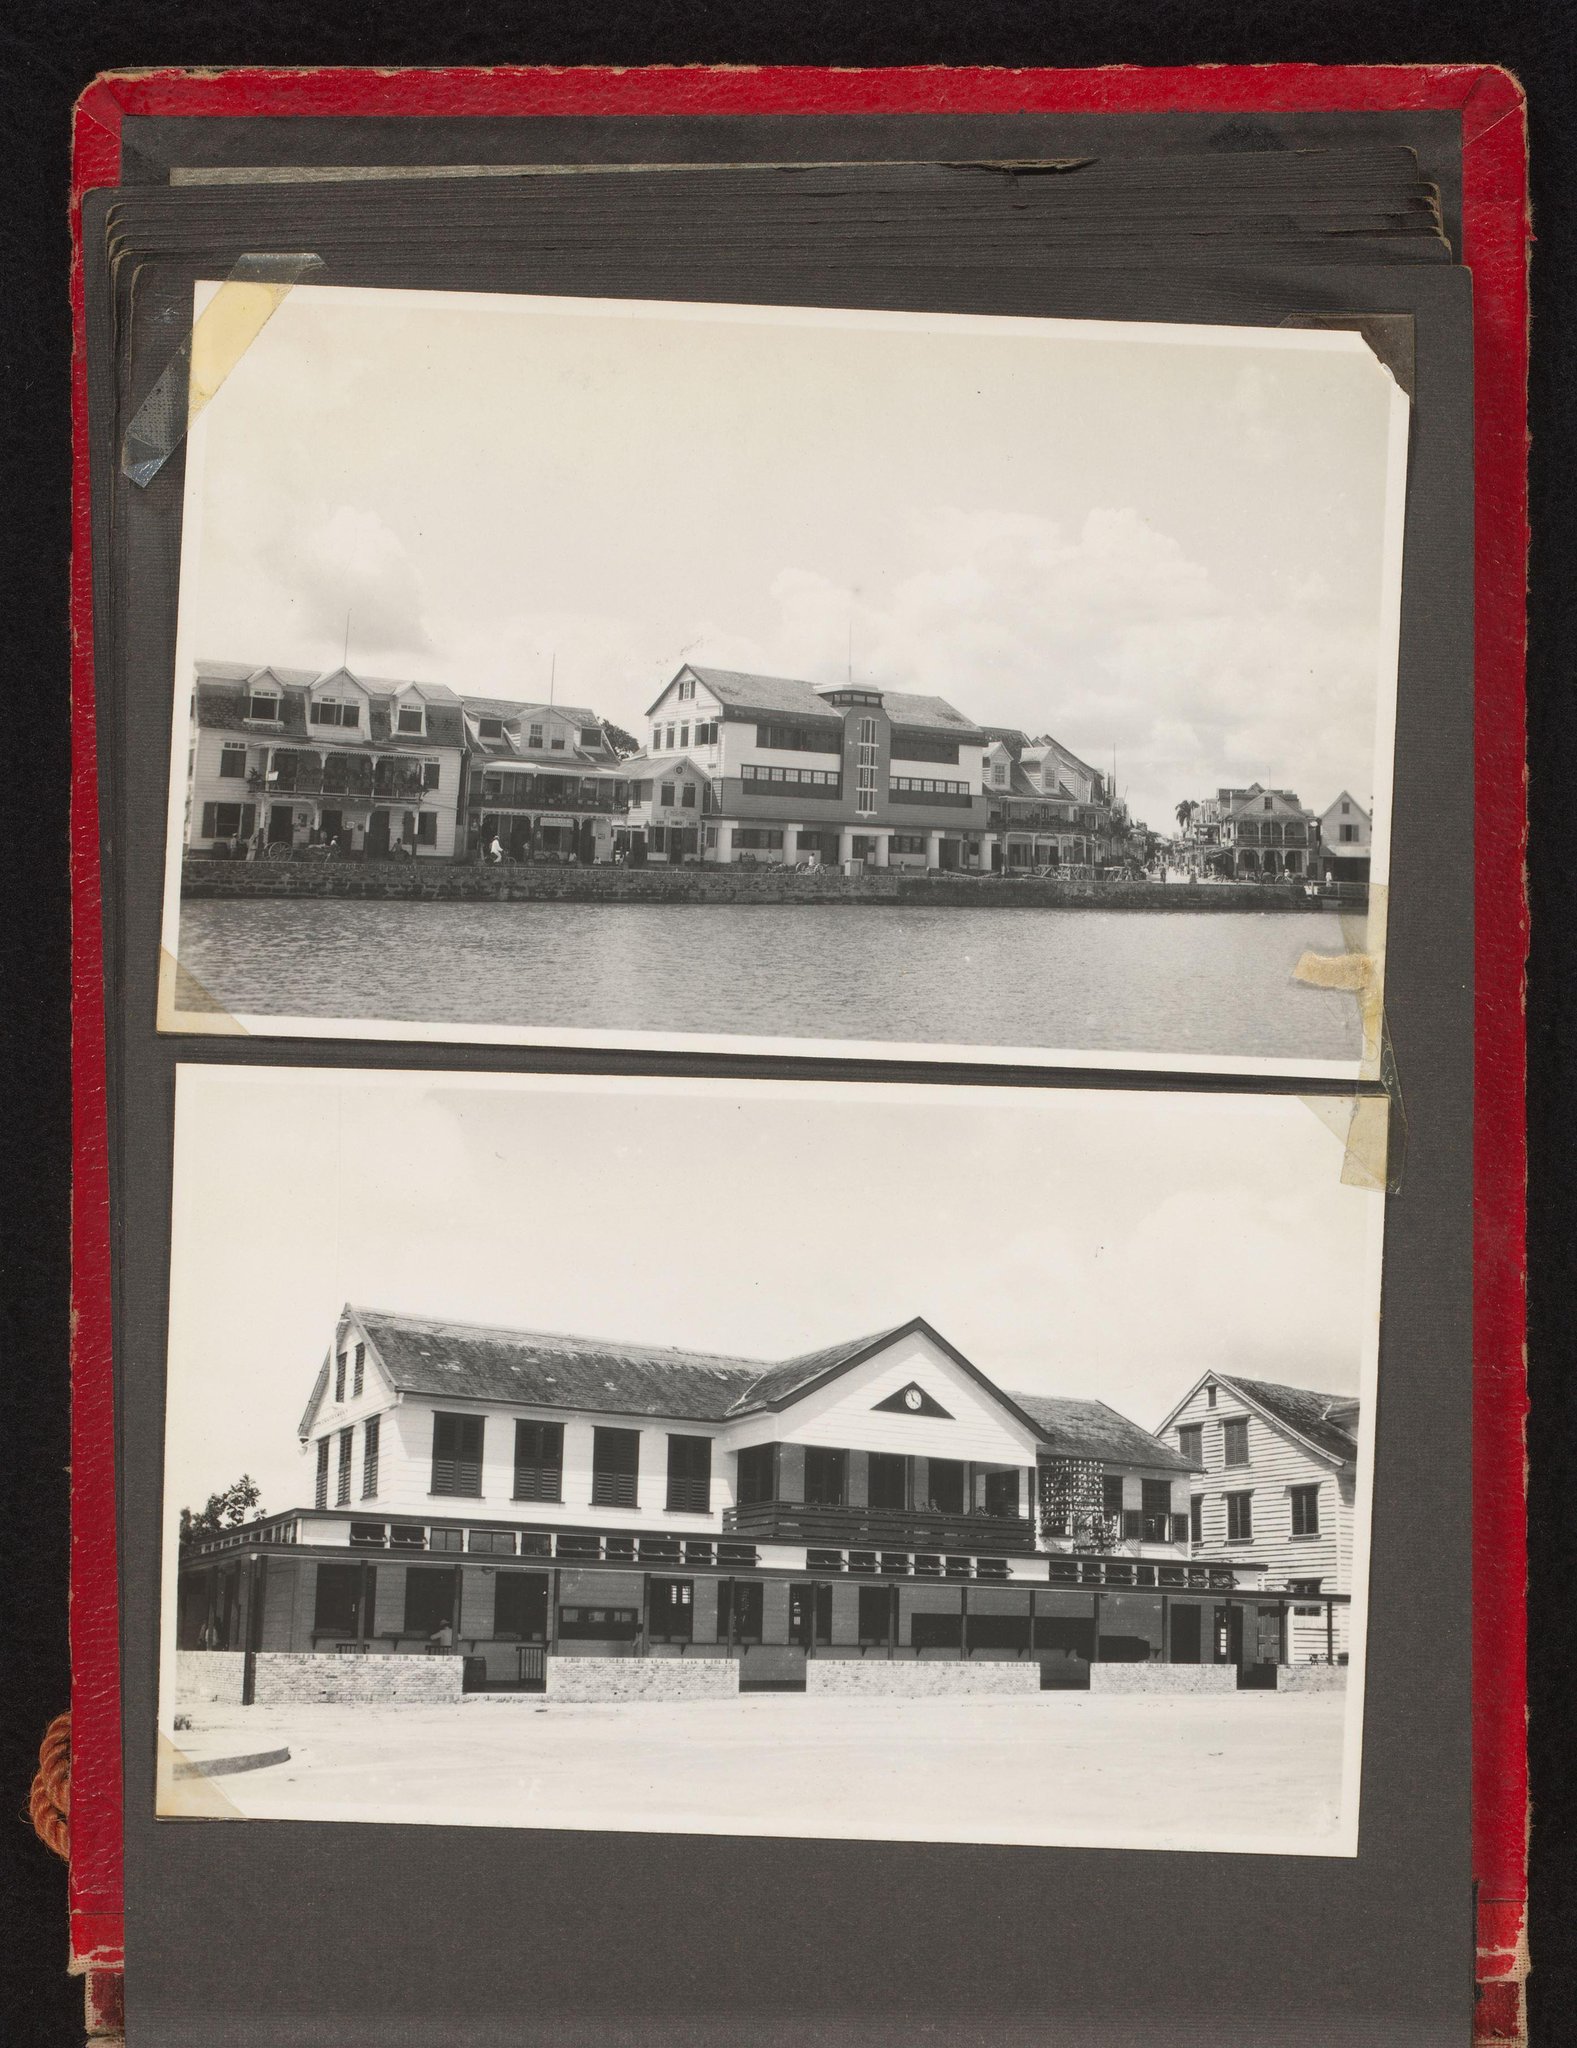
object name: photograph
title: Paramaribo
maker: Anonymous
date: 1925-1935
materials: paper, photographic support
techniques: gelatin silver print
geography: suriname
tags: public road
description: Albumblad met twee (gekochte) foto's van gebouwen te Paramaribo. Onderdeel van het fotoalbum van Theodoor Brouwers over Suriname ca. 1930.